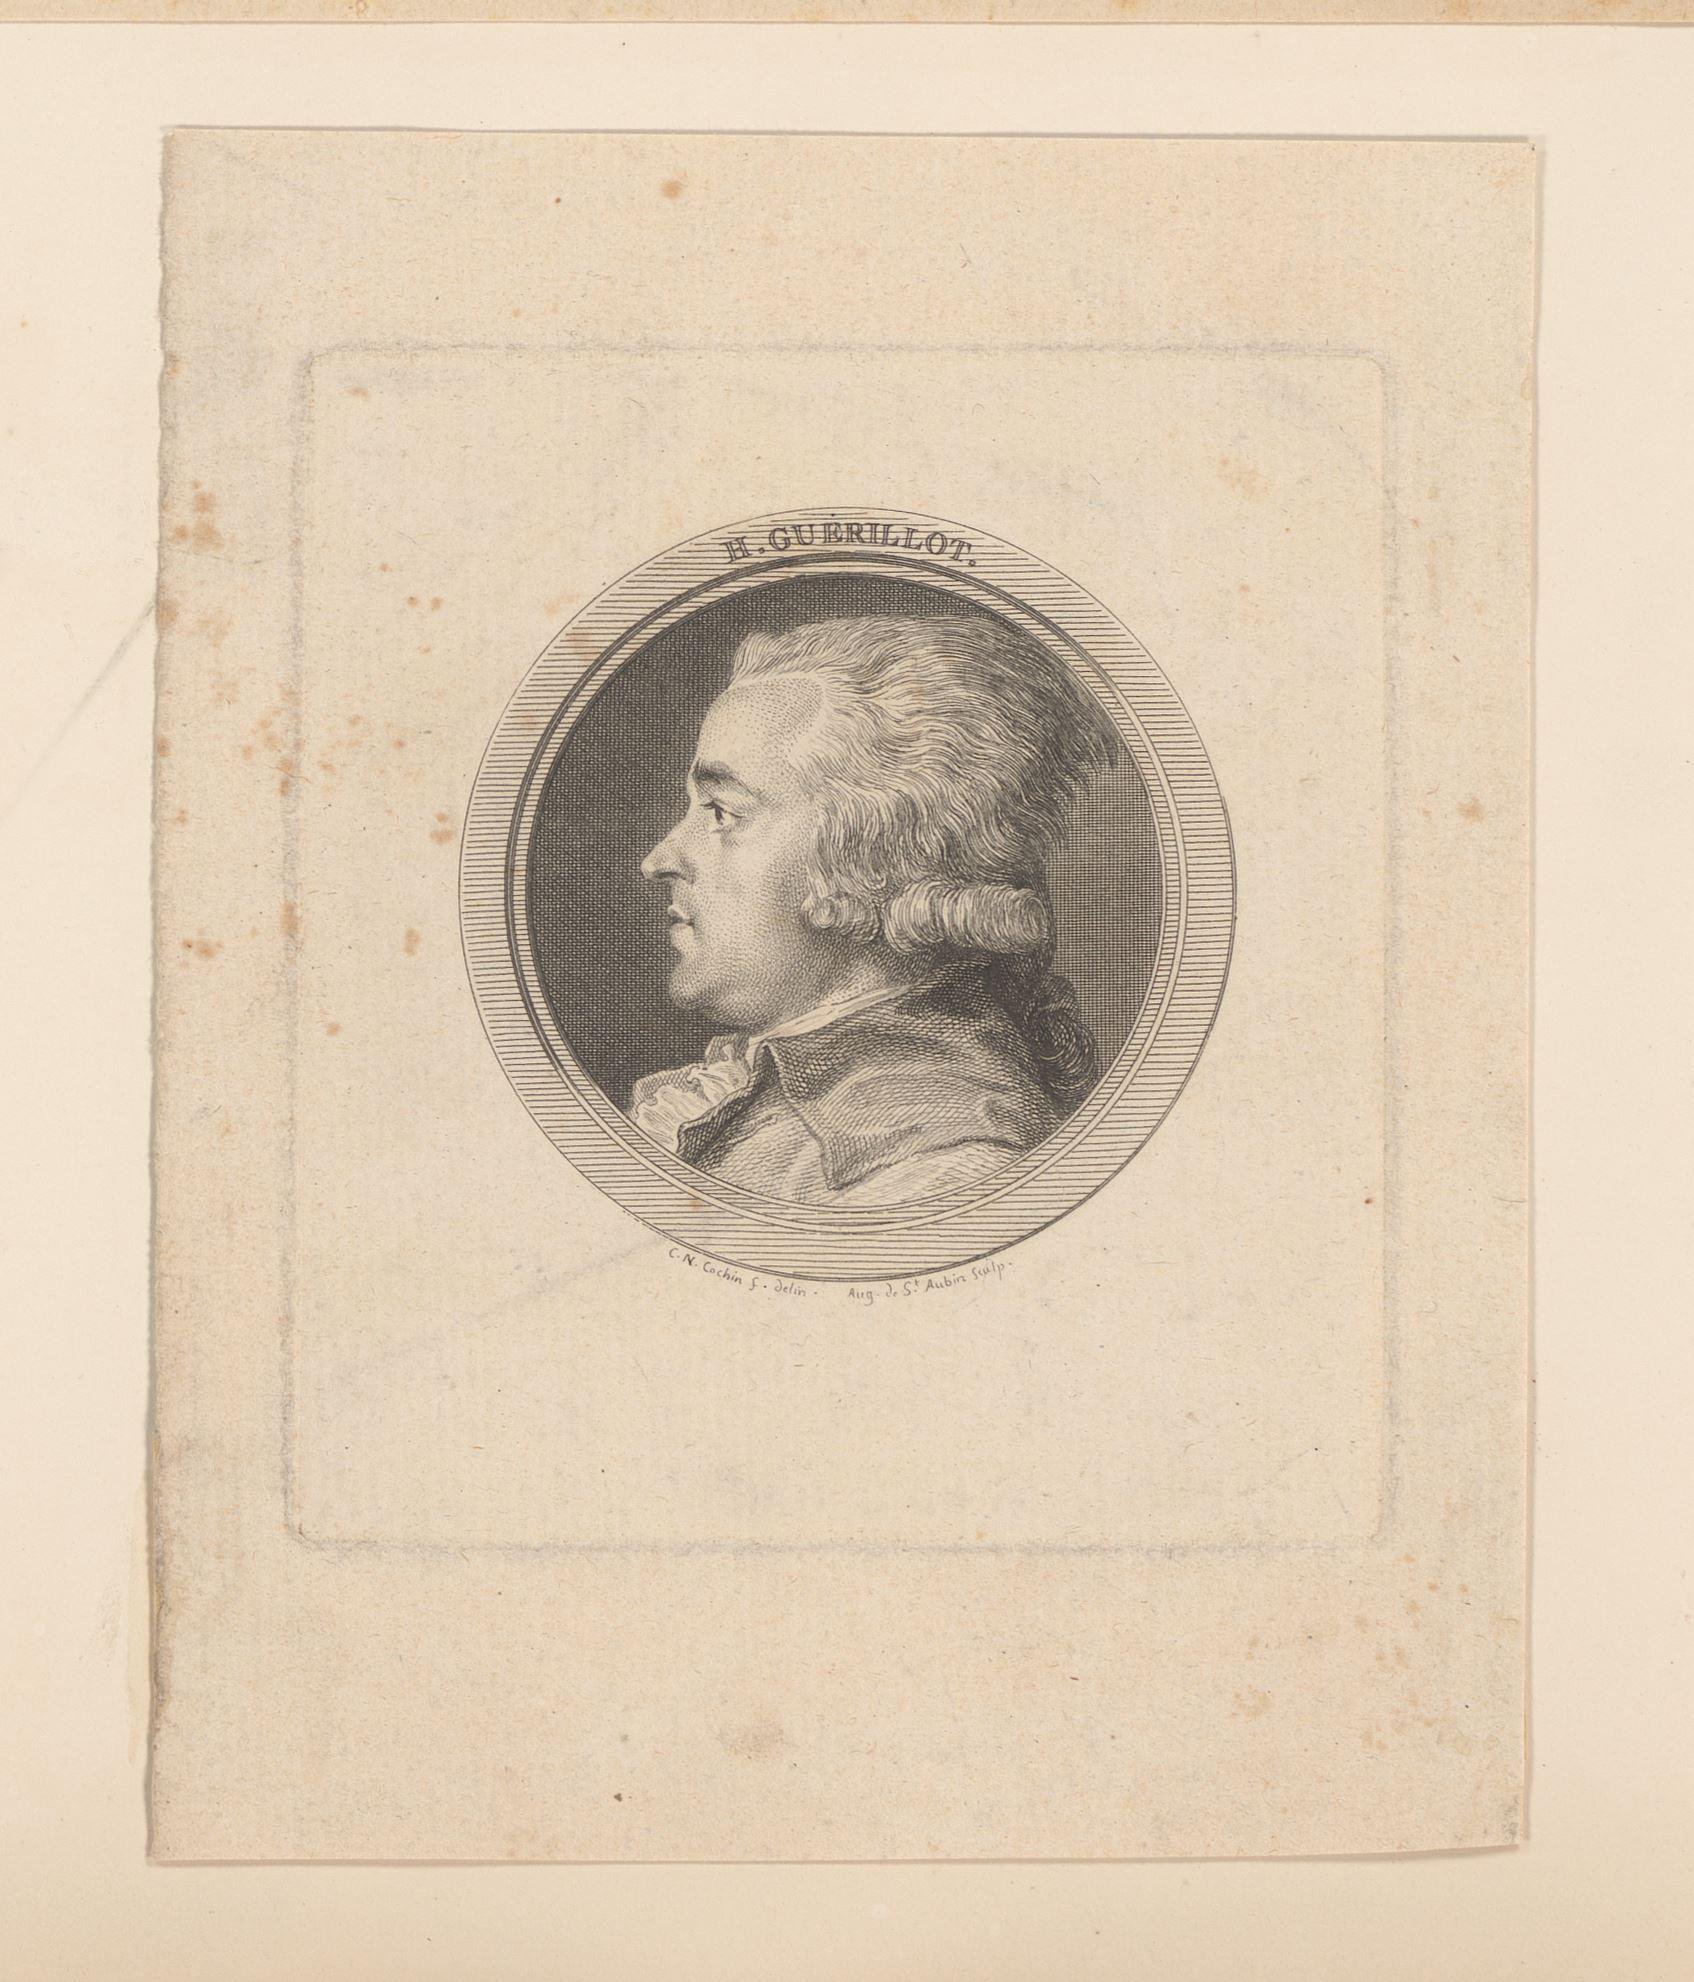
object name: album leaf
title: H. Guerillot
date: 1746-1807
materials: paper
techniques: engraving, etching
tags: historical persons, portrait of a musician